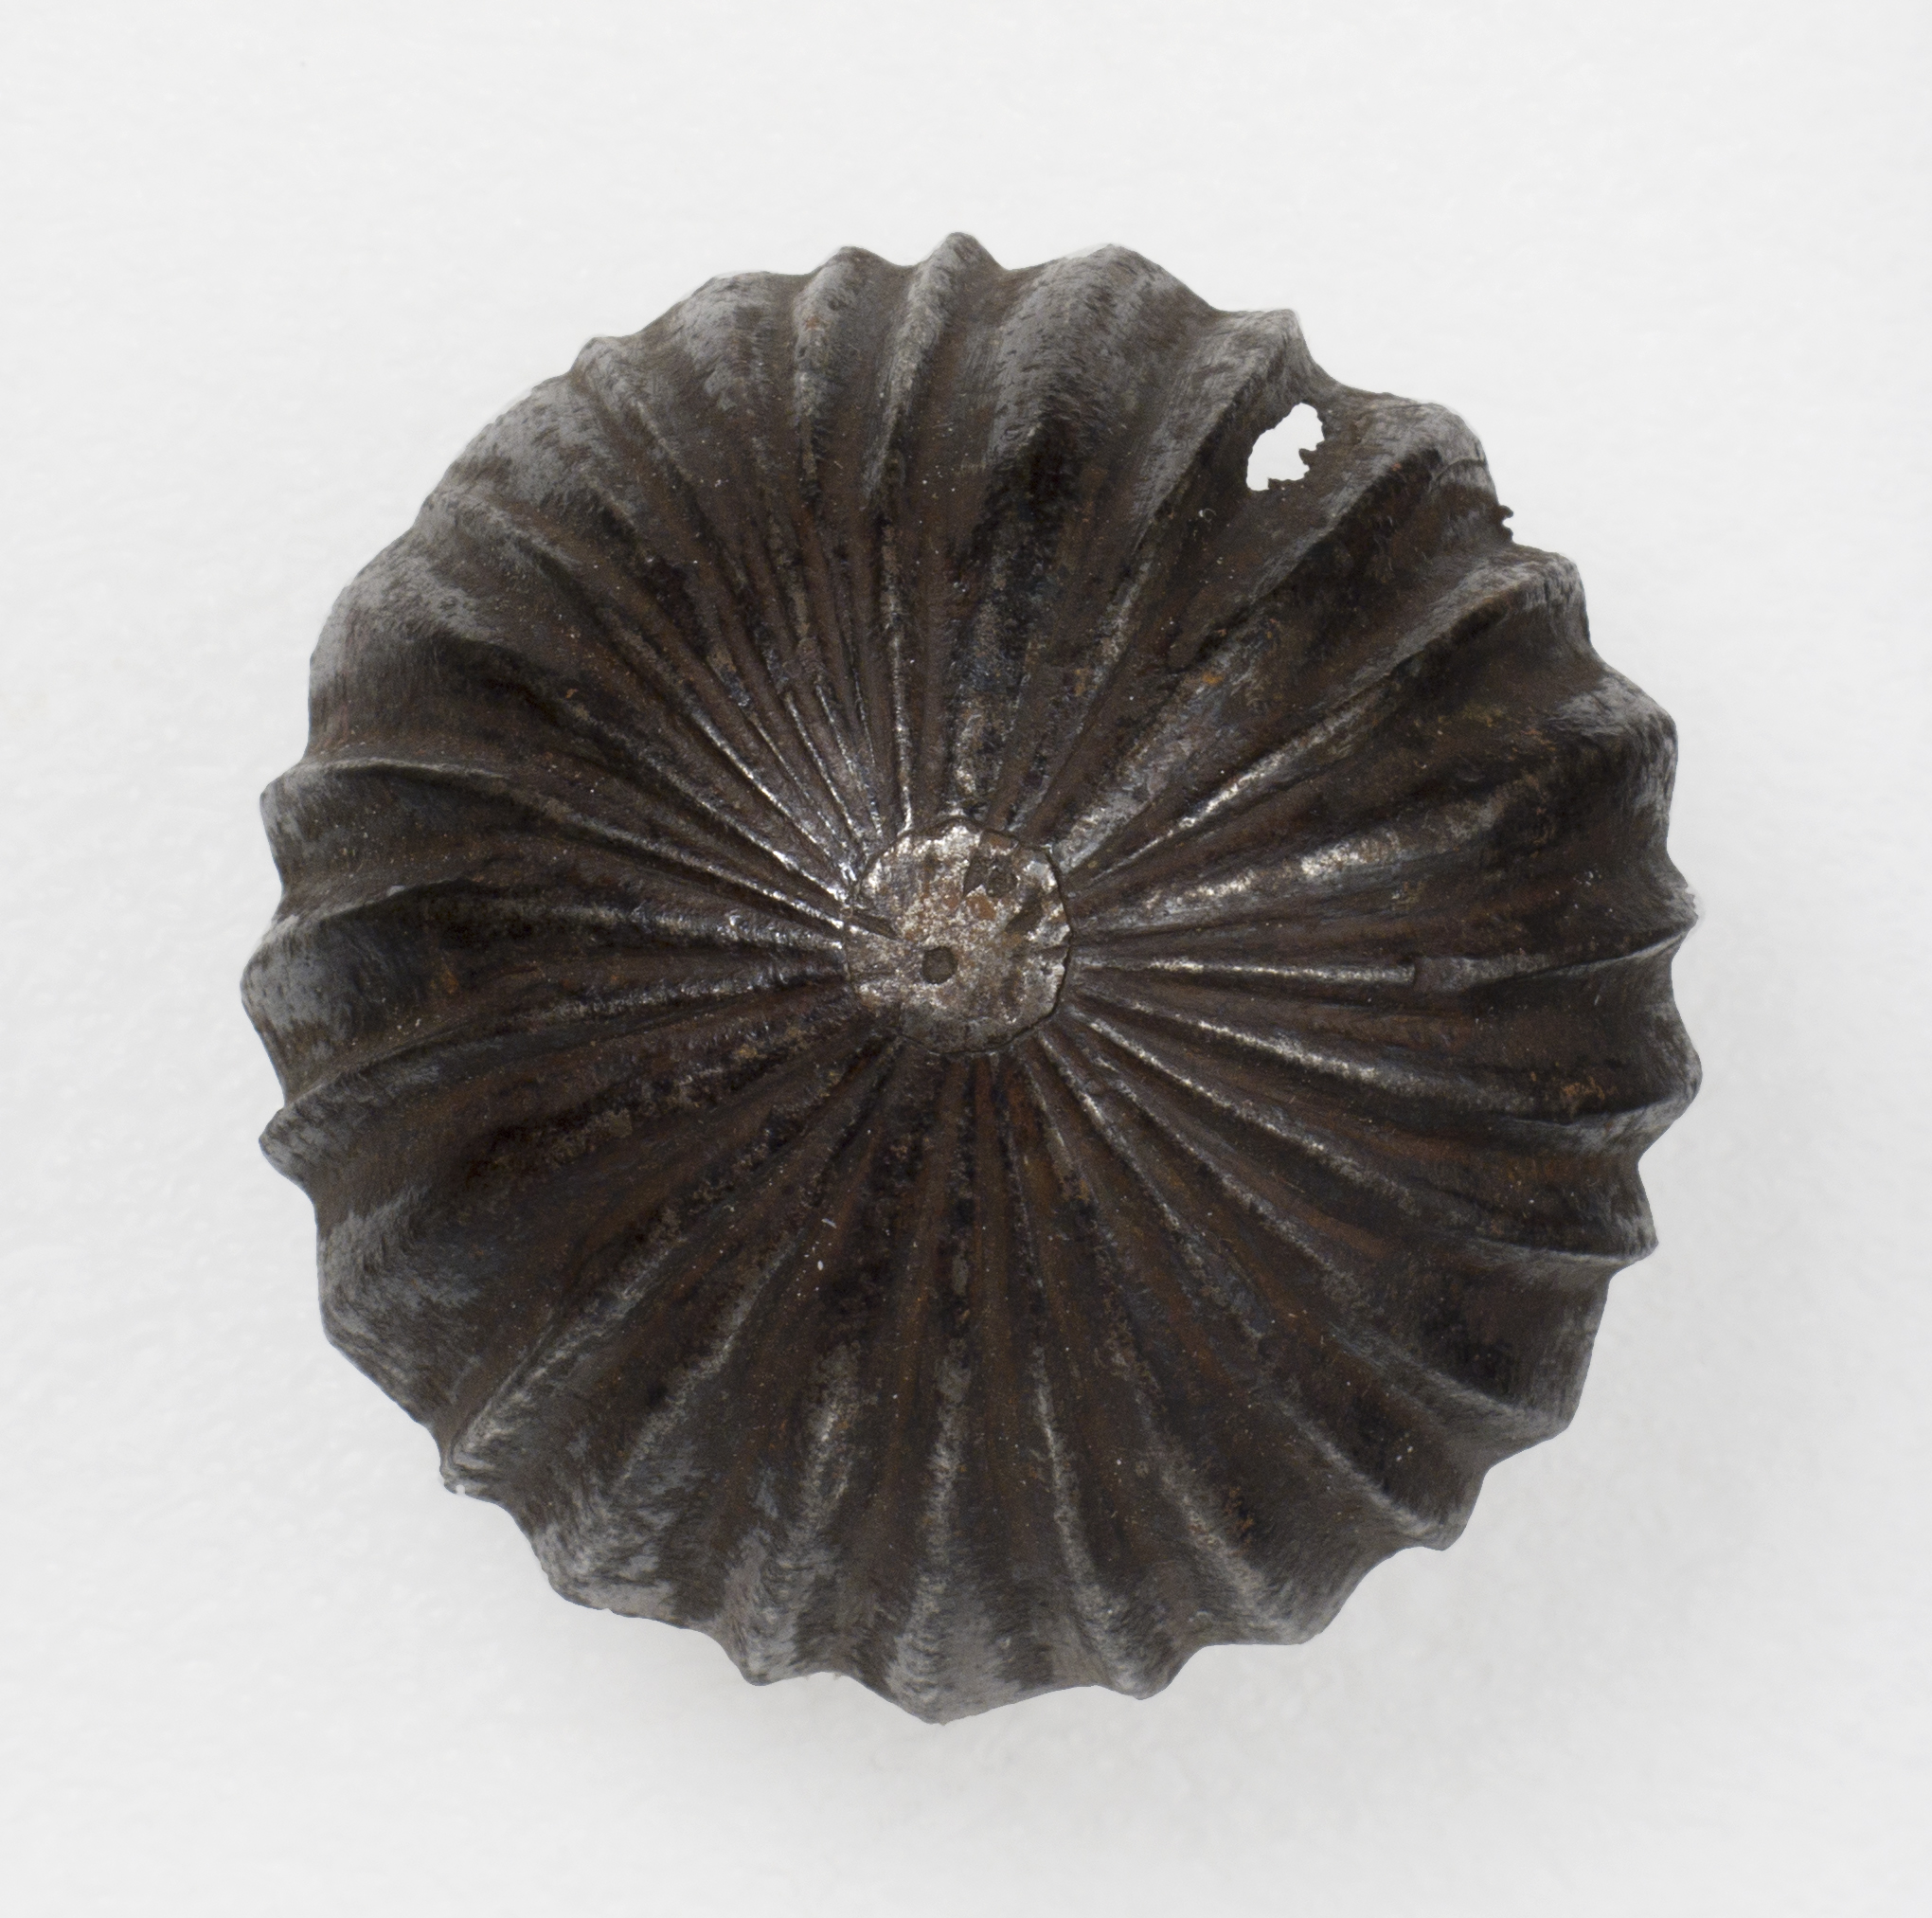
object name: nail head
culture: european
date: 1401-1600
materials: iron